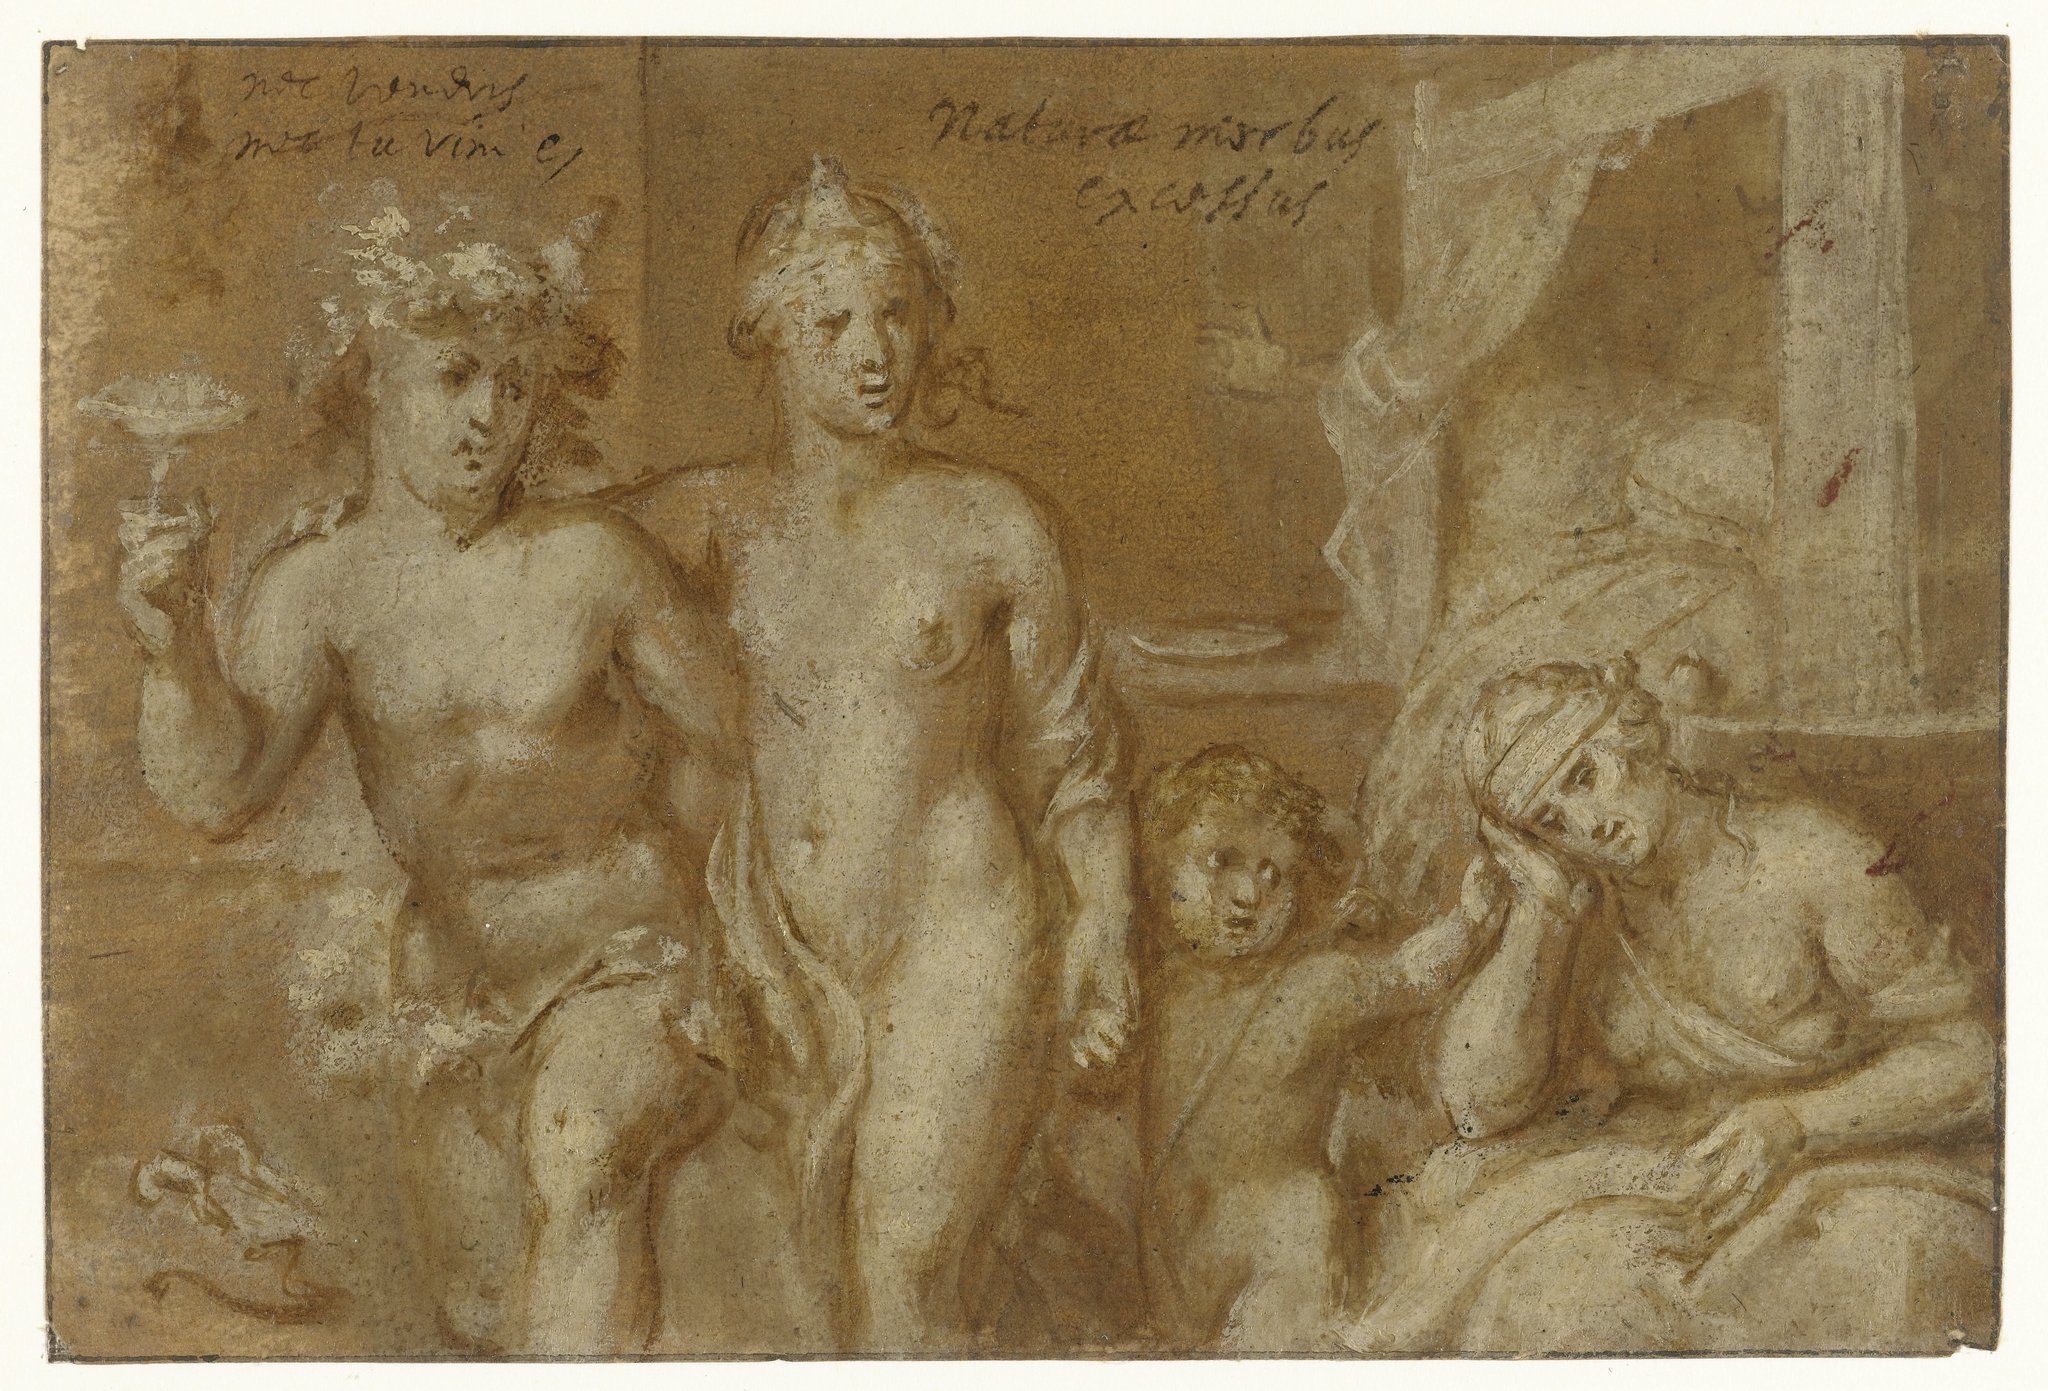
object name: drawing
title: Gevolgen van de omgang met Bacchus en Venus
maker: otto van veen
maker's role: draughtsman, painter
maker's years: 1556-1629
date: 1566-1629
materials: oil, paper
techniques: grisaille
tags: (story of) bacchus (dionysus), liber, the mind affected by drink, drugs or stimulants, (story of) venus (aphrodite), lovesick lover